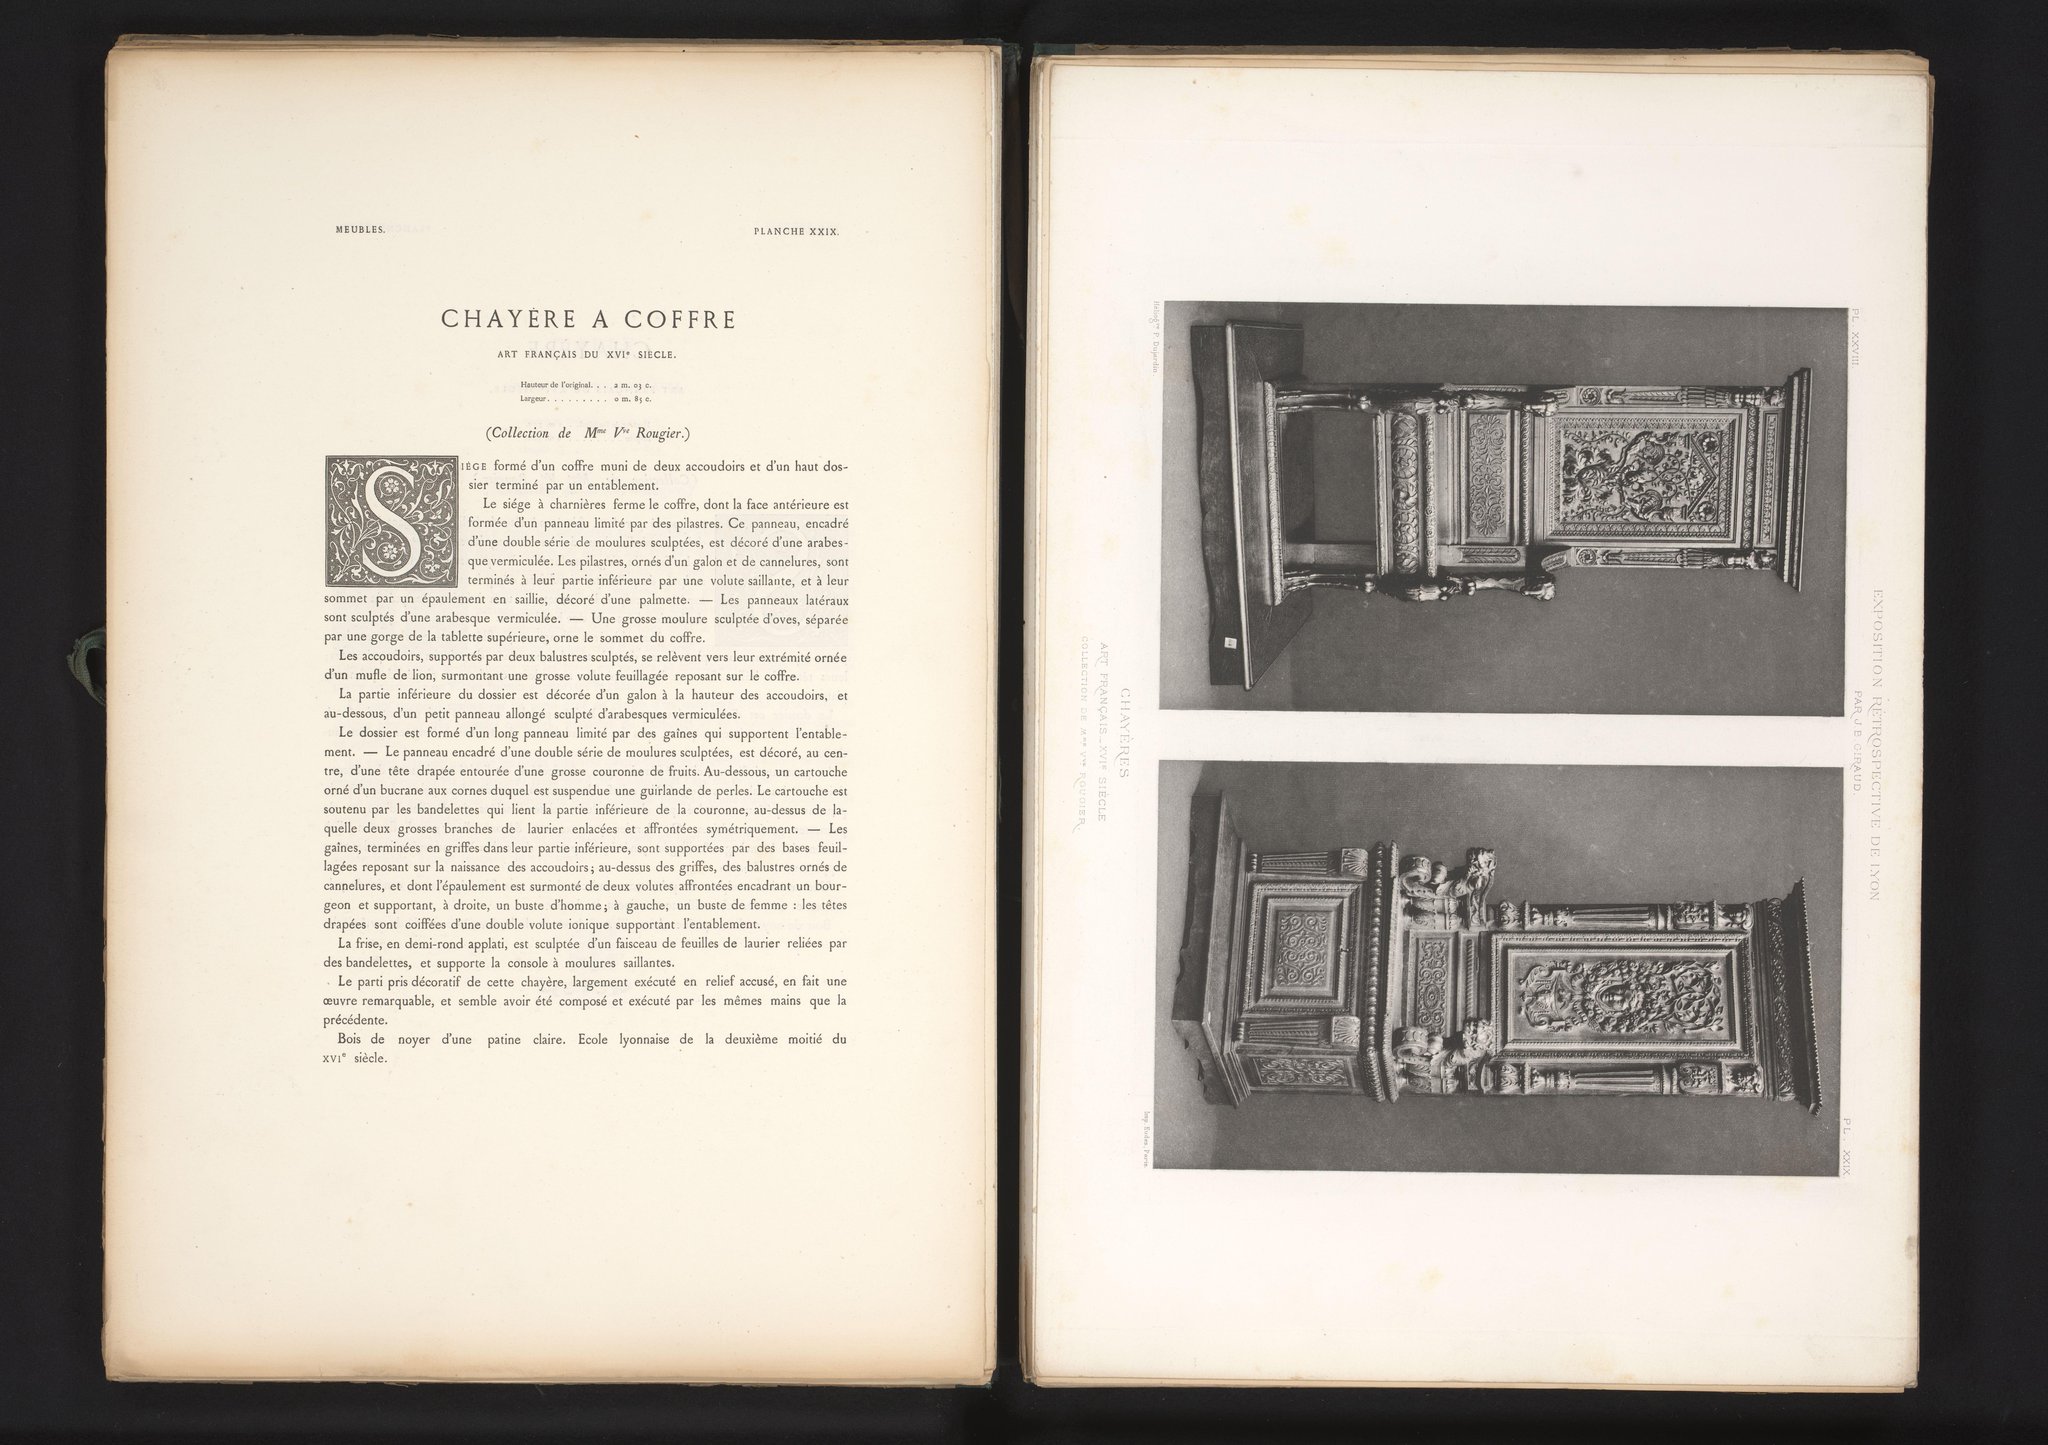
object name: photomechanical print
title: Twee 16de-eeuwse Franse zetels van hout, op de Exposition Rétrospective van 1877 in Lyon, Frankrijk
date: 1877-1878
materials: paper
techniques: photoaquatint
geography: lyon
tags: chair (+ wood and other phytogenic material), lyon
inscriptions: number: ‘PL. XXVIII.’, number: ‘PL. XXIX.’, inscription: ‘EXPOSITION RÉTROSPECTIVE DE LYON/ PAR J. B. GIRAUD.’, inscription: ‘CHAYÈRES/ ART FRANÇAIS_XVIe SIÈCLE/ COLLECTION DE Mme Vve ROUGIER.’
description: Deze prenten maken deel uit van een omslag met 79 prenten op 54 bladen en 65 tekstbladen.